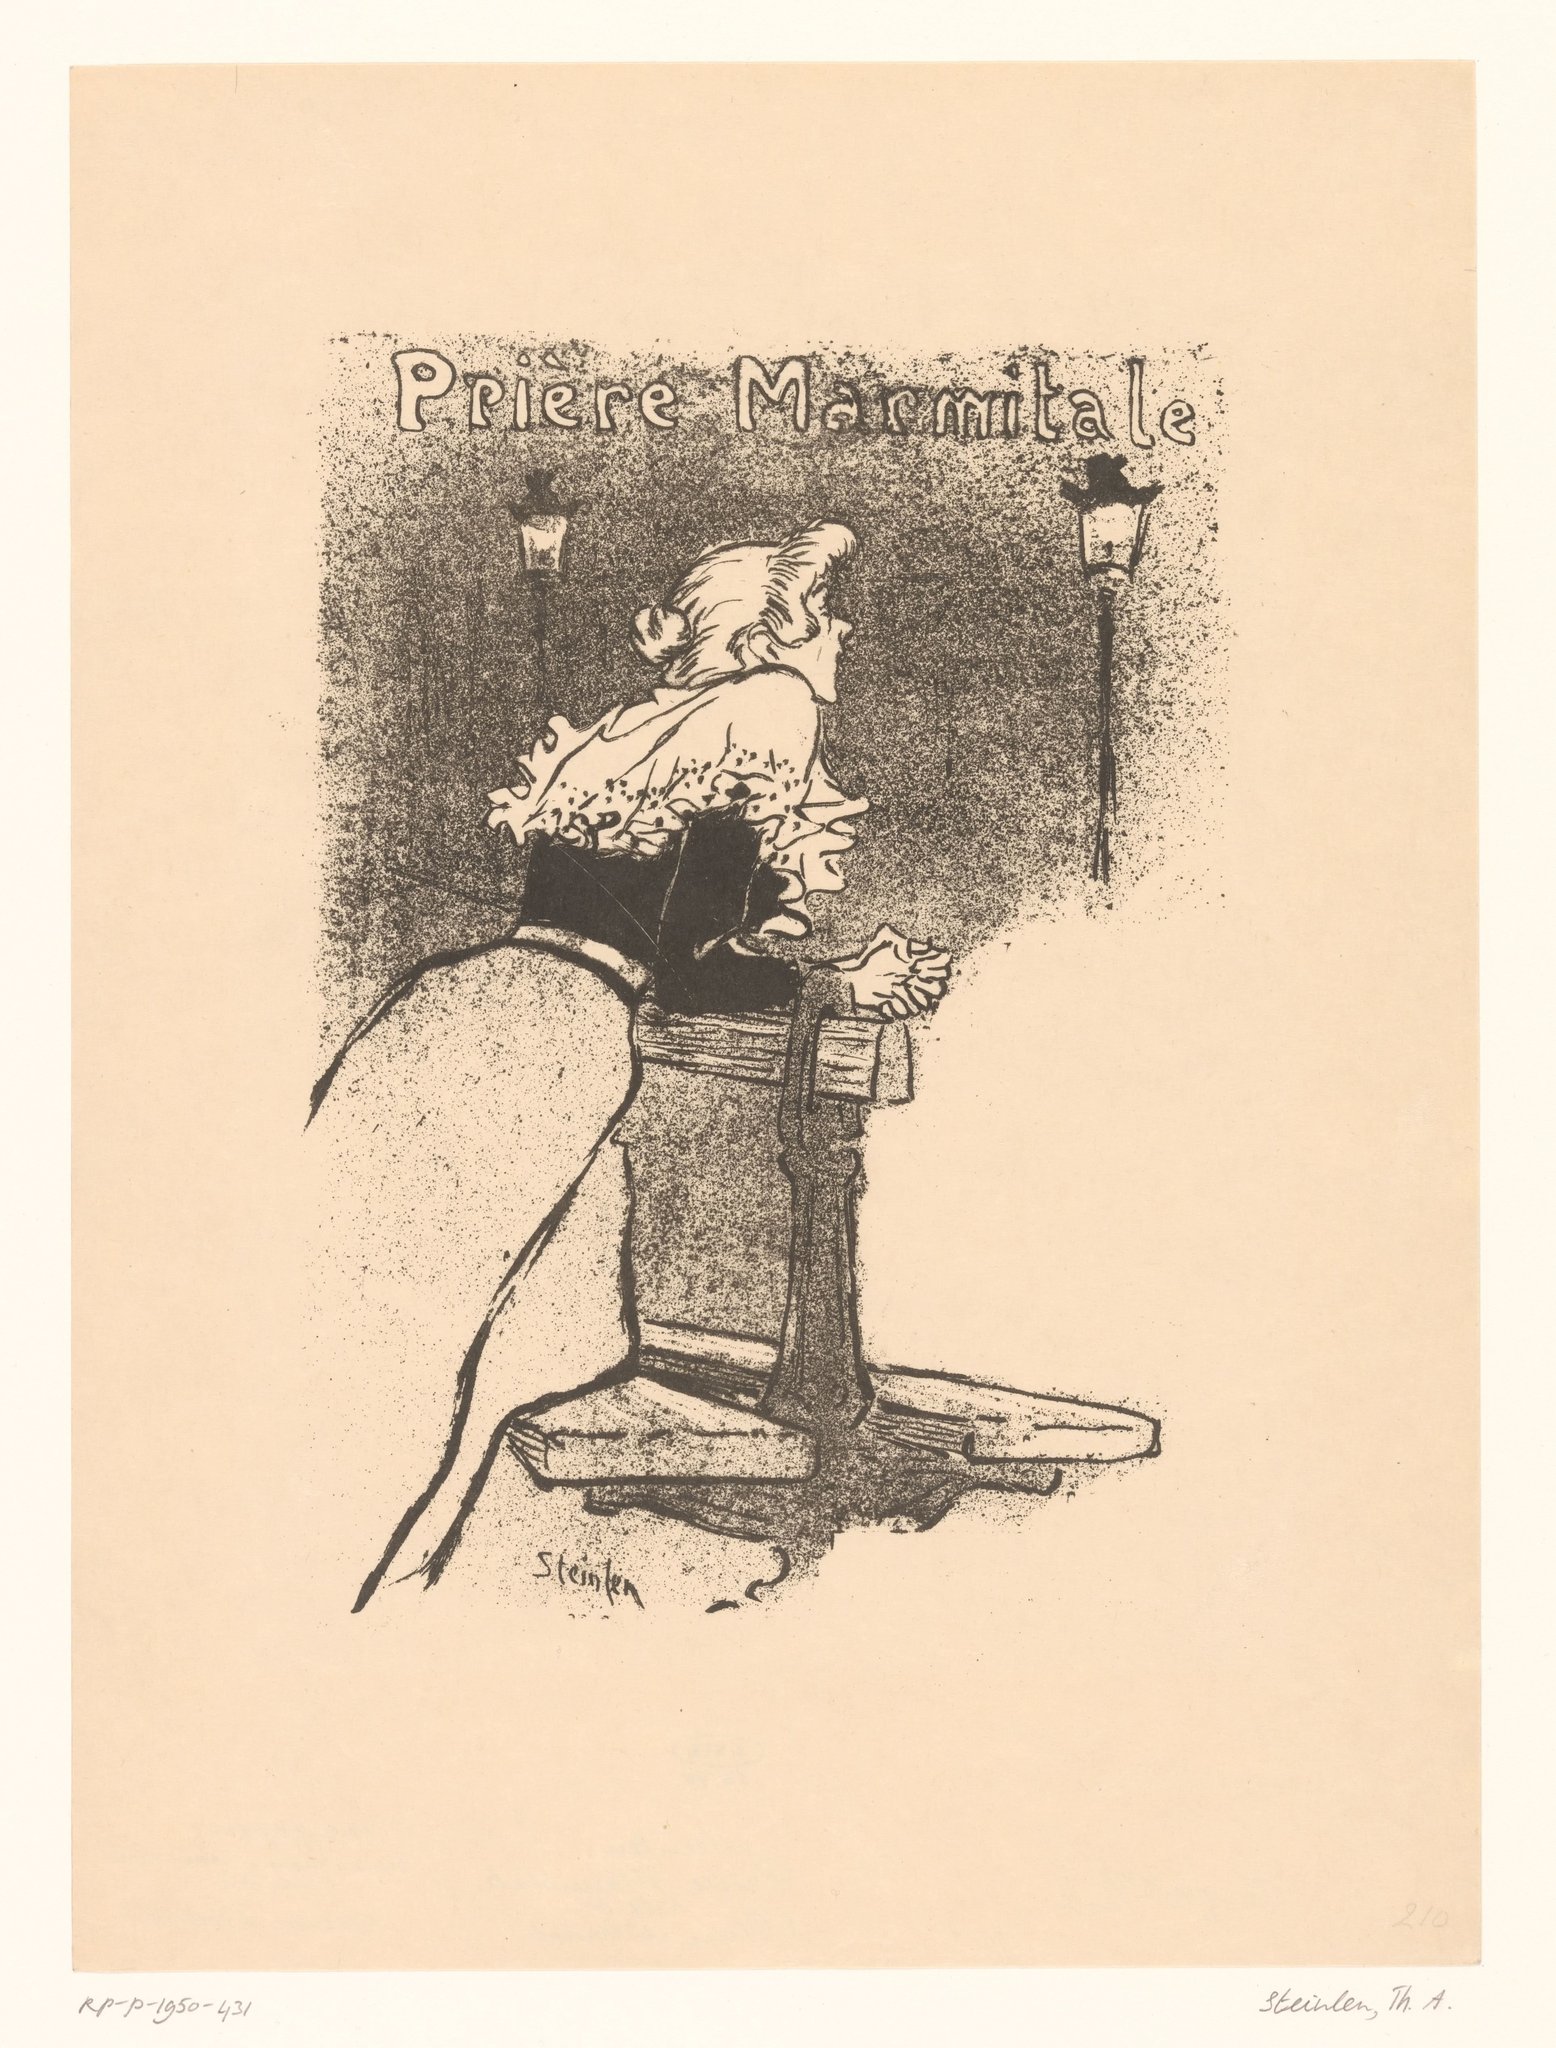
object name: print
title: Ontwerp voor omslag voor: Prière marmitale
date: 1894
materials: paper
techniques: lithograph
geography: paris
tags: female sex; woman, street lighting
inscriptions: collector's mark: Lugt 2228